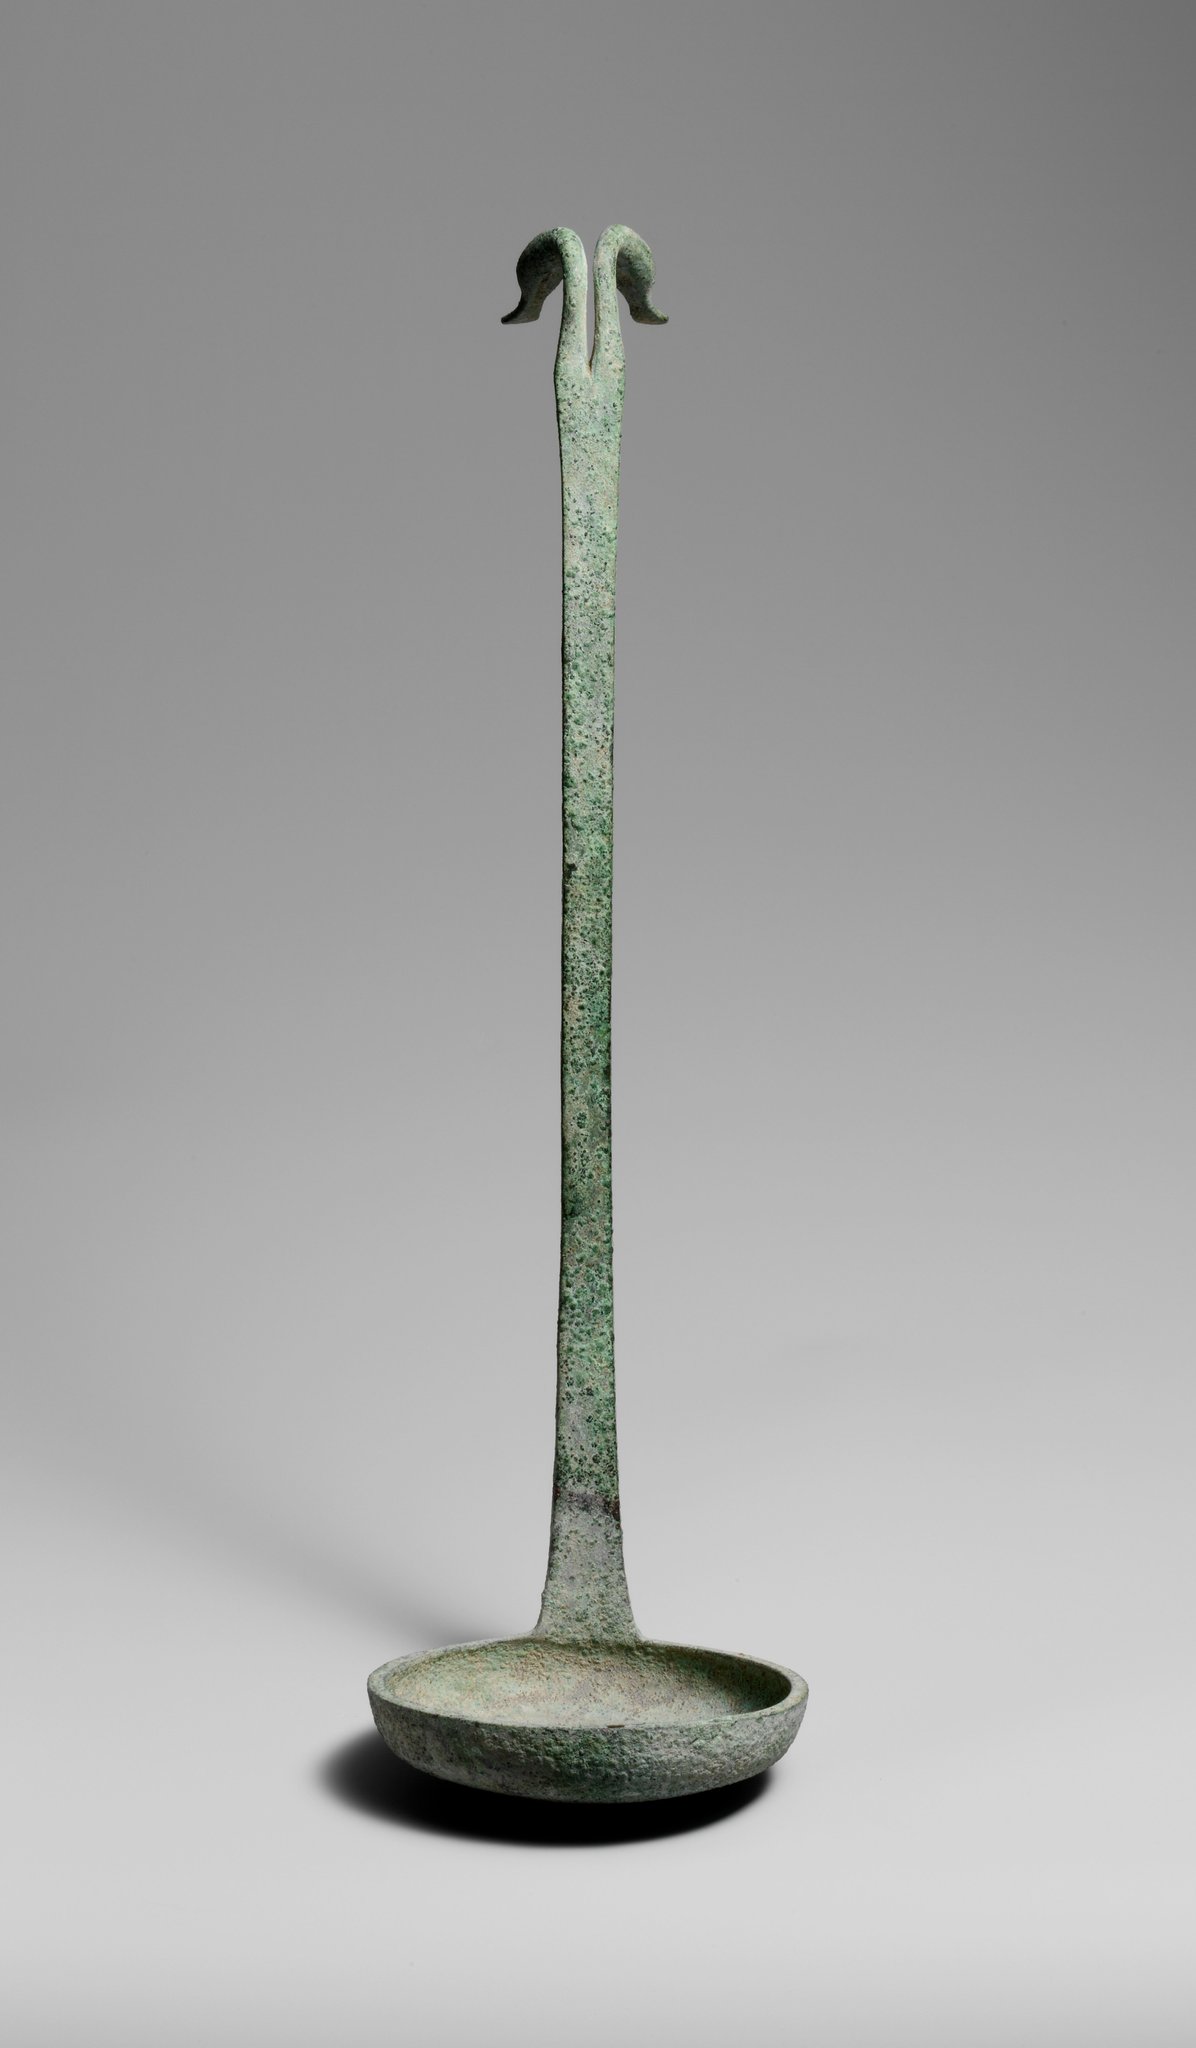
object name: ladle with handle of ducks' head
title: Bronze ladle terminating in two ducks' heads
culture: etruscan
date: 500-401 BCE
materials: bronze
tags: ducks